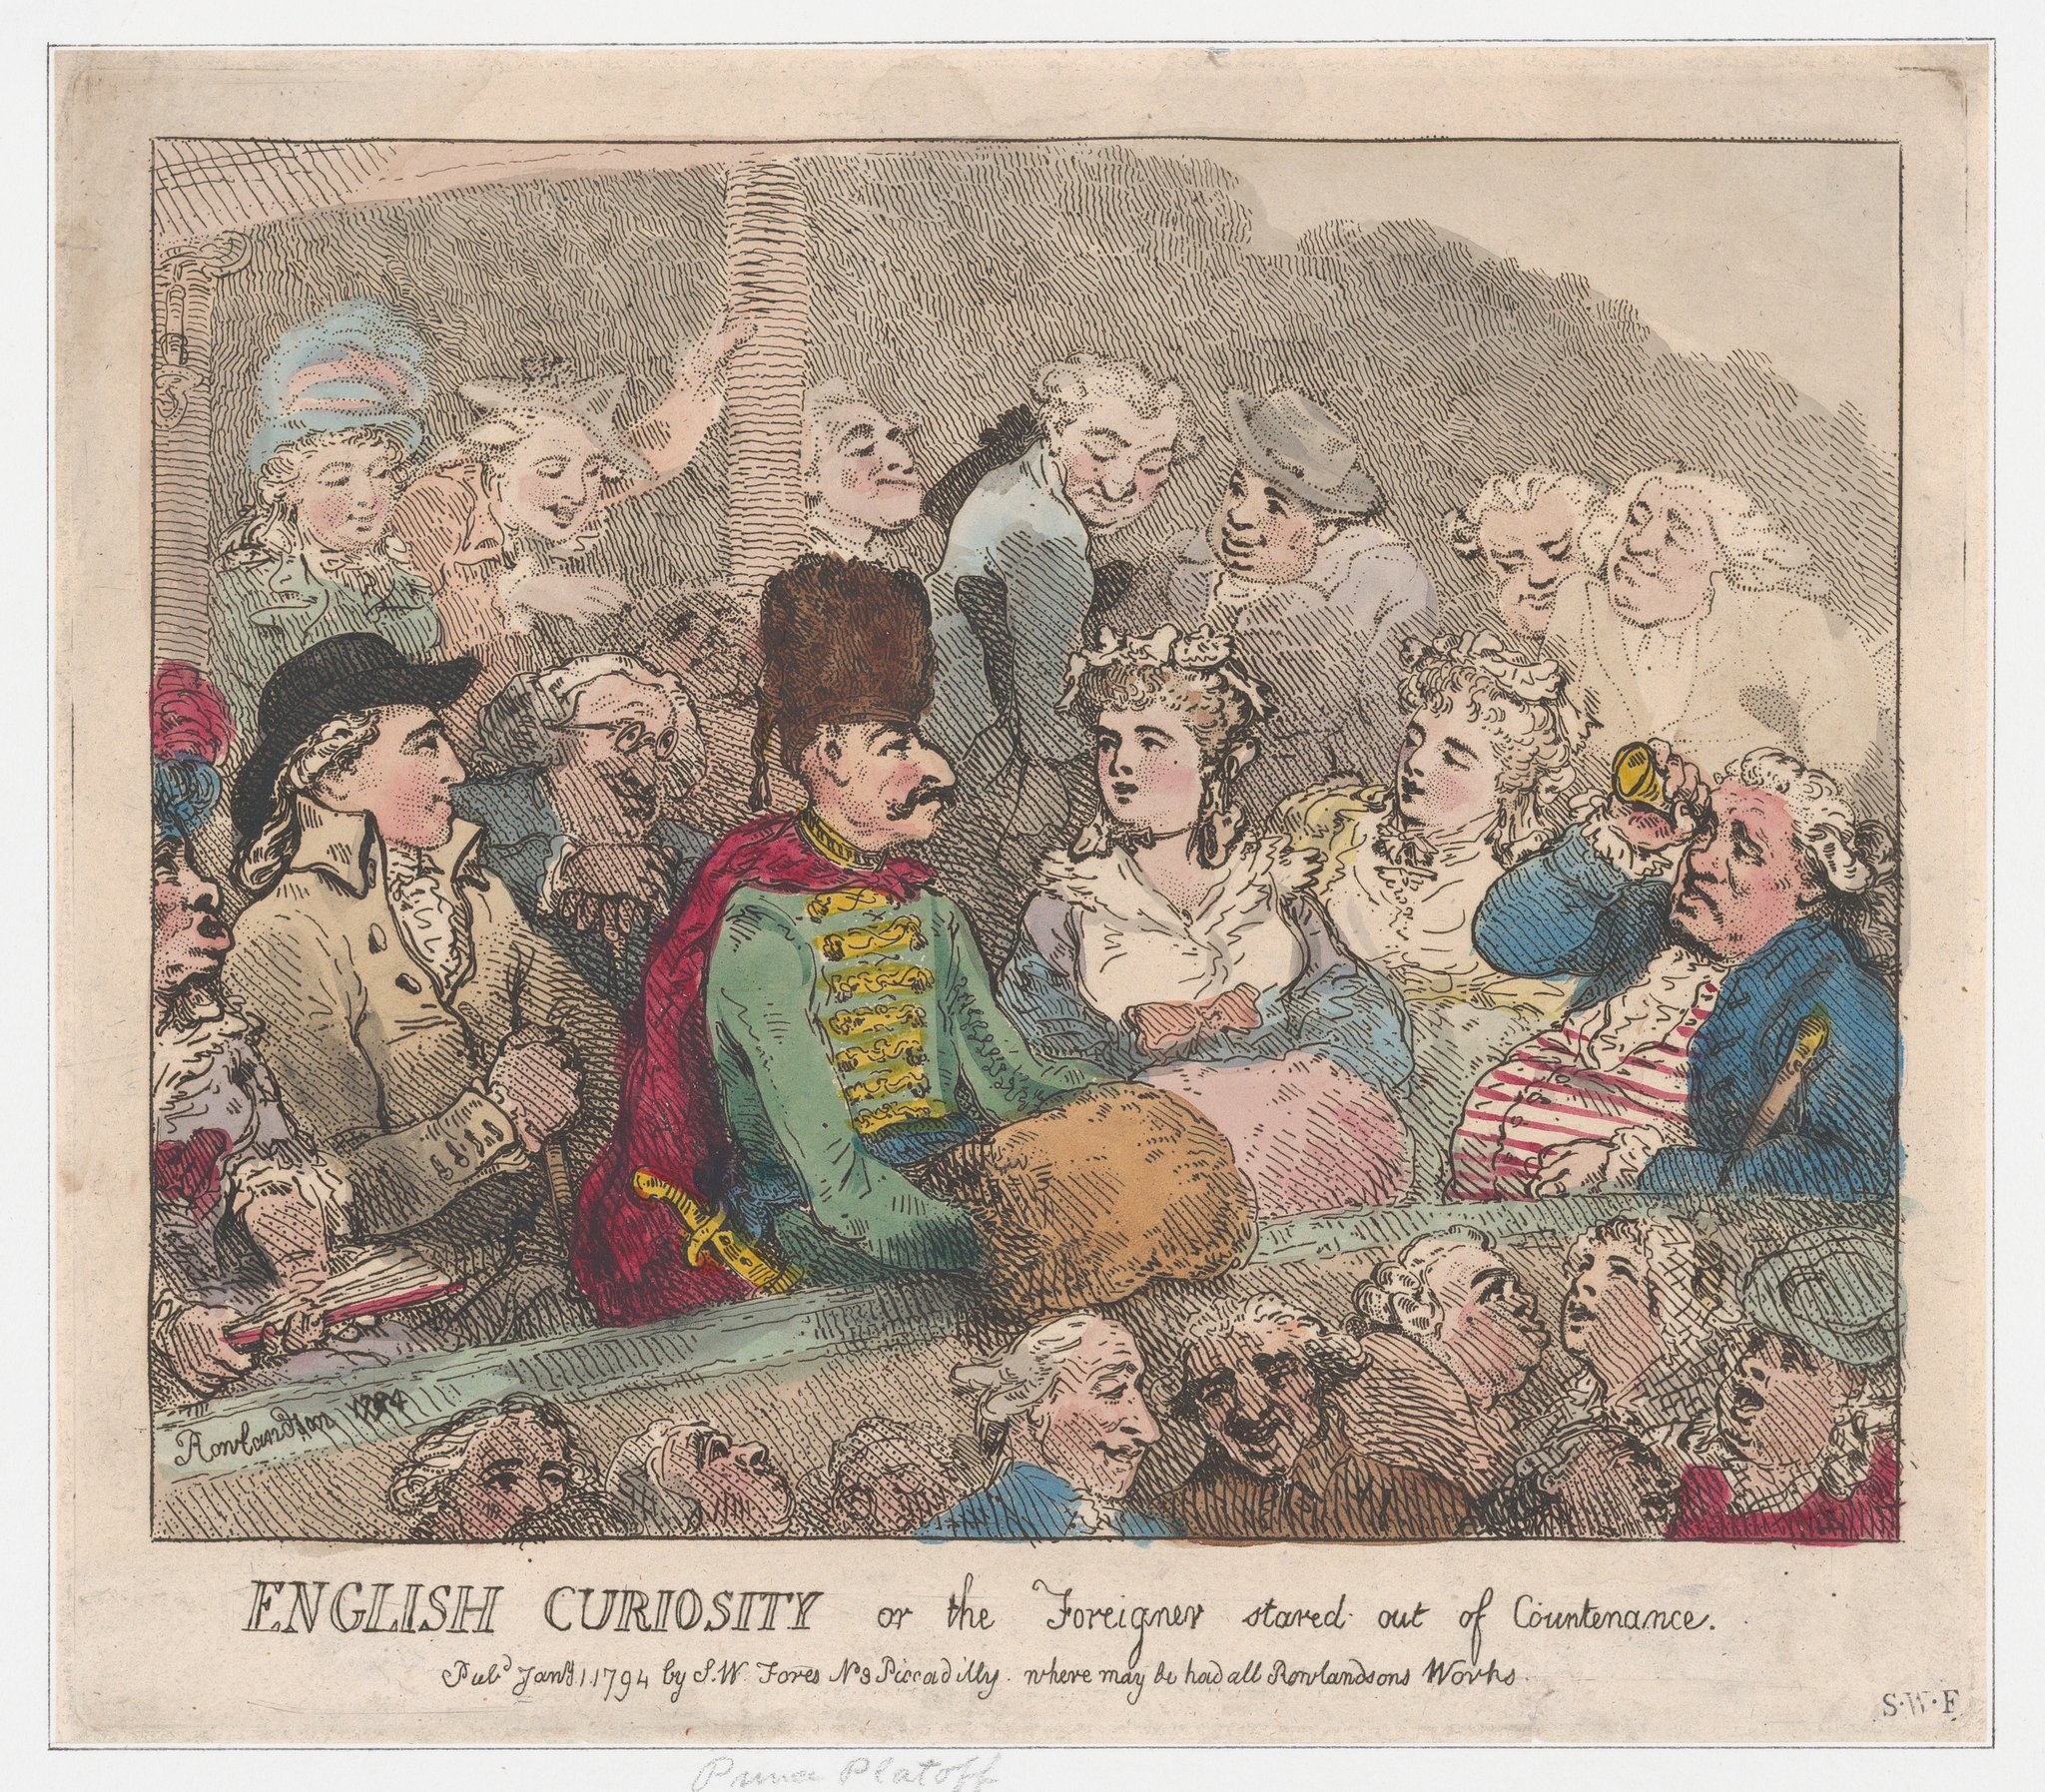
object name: print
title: English Curiosity or The Foreigner Stared Out of Countenance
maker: thomas rowlandson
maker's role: artist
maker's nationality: british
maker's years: 1757-1827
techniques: etching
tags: men,women